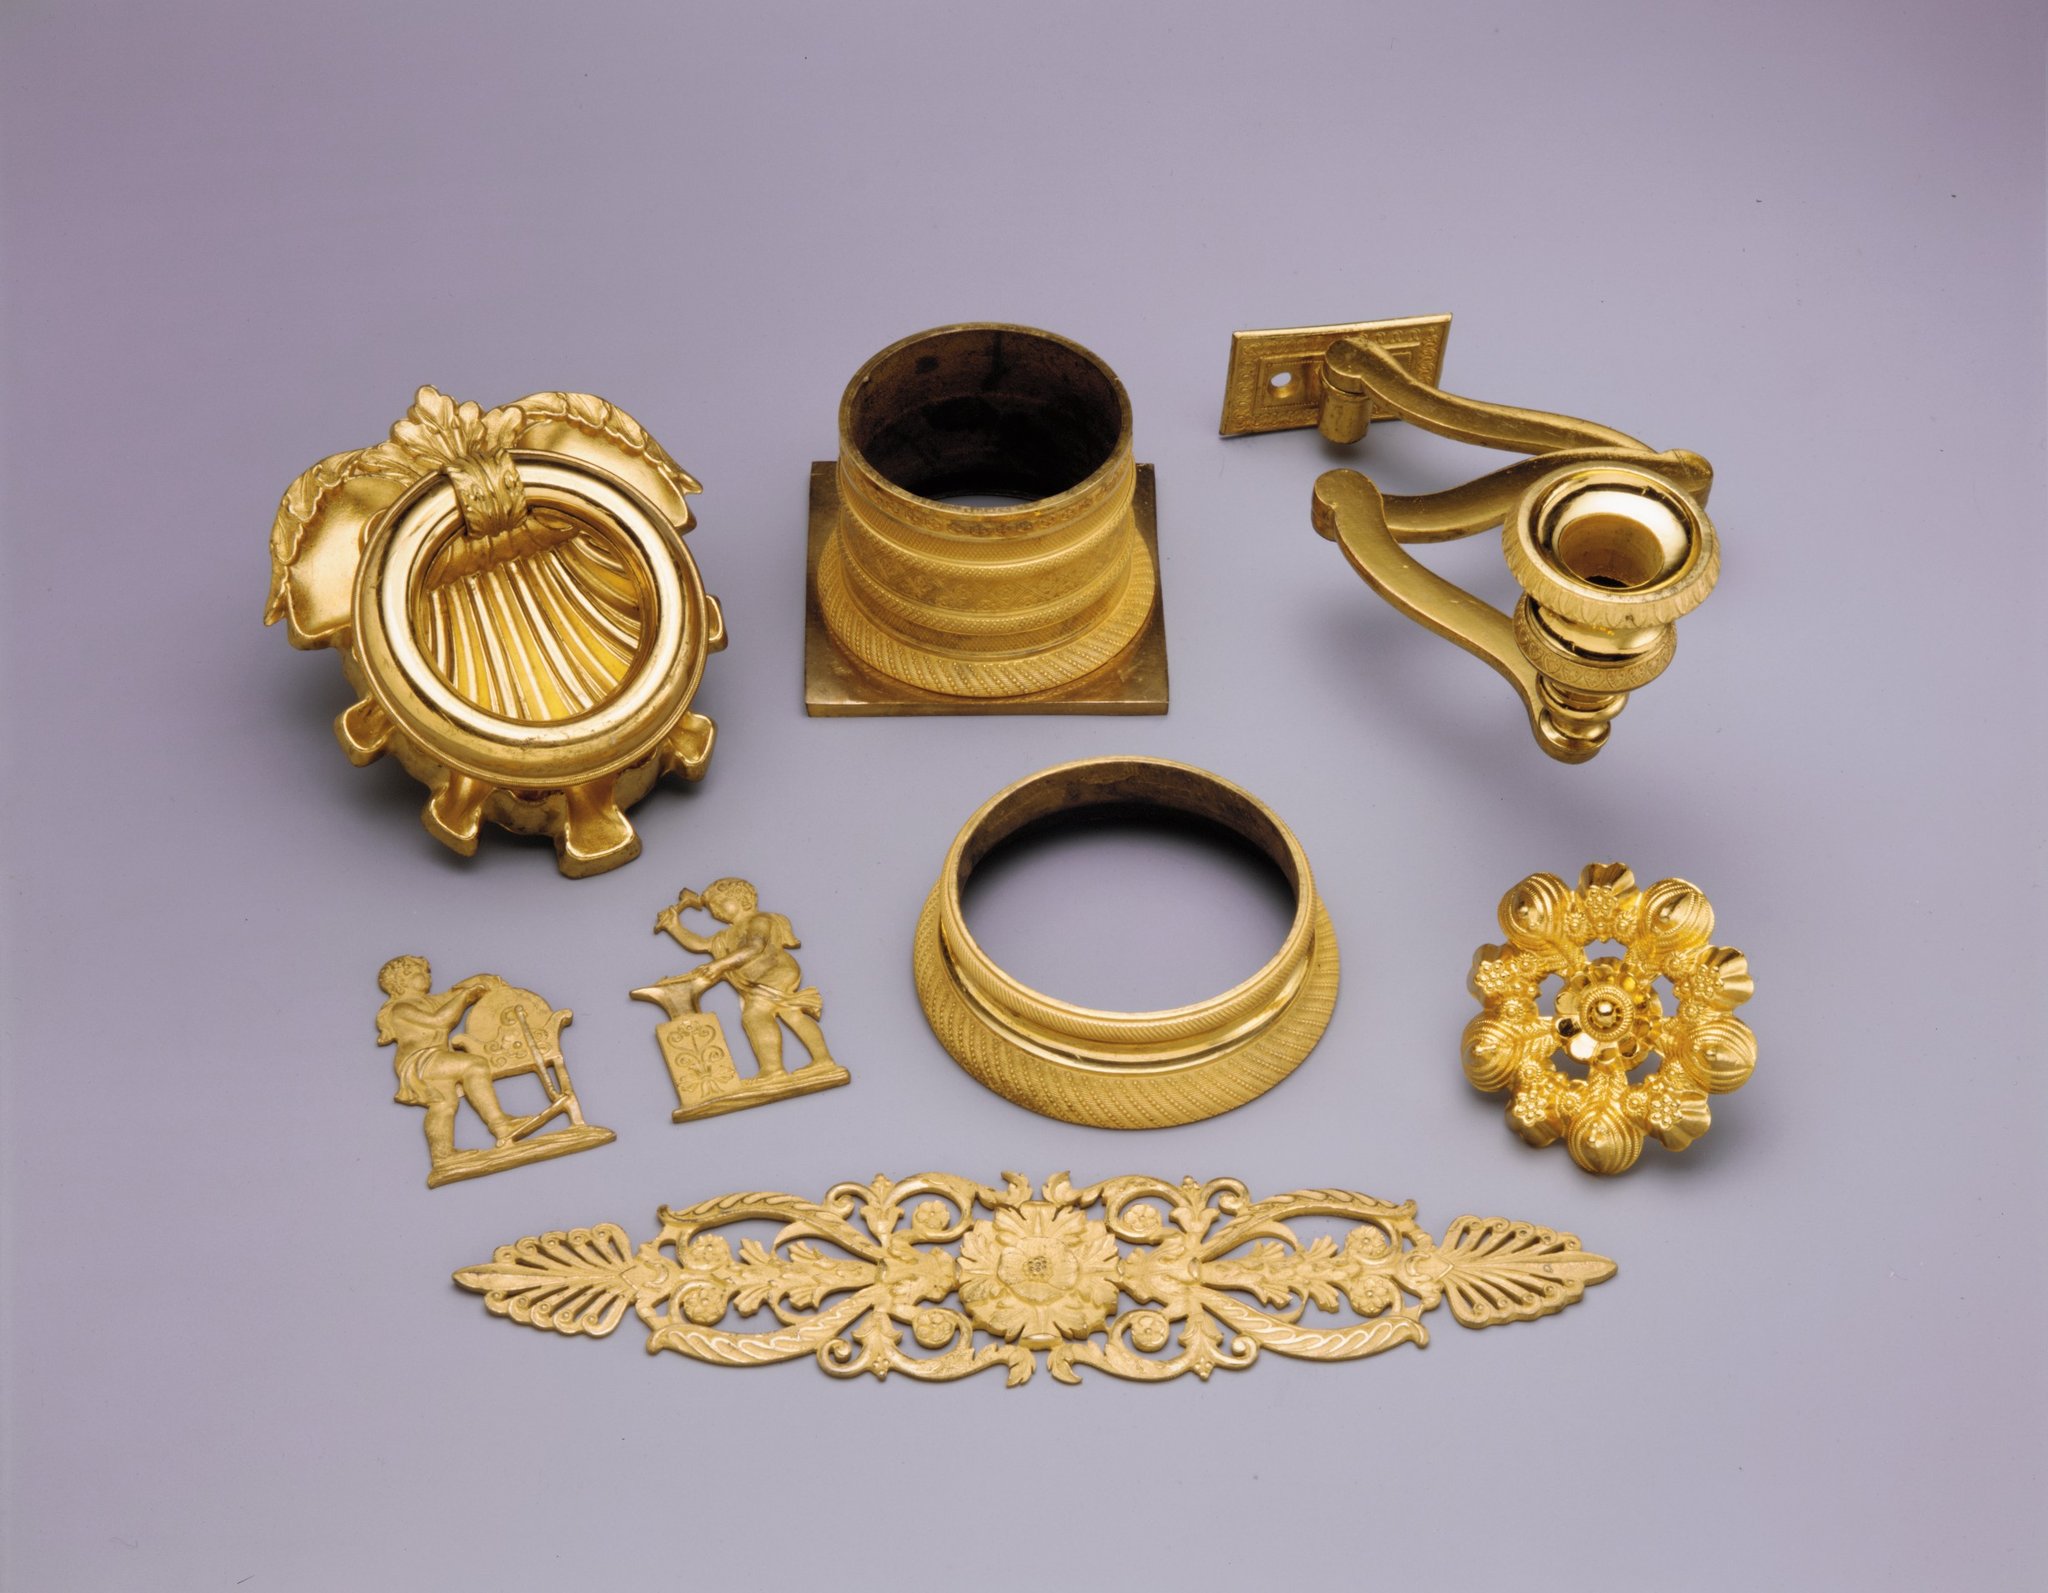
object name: furniture hardware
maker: henry kellam hancock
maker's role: retailer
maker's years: 1816-1851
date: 1820-1830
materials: brass, gilt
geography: france